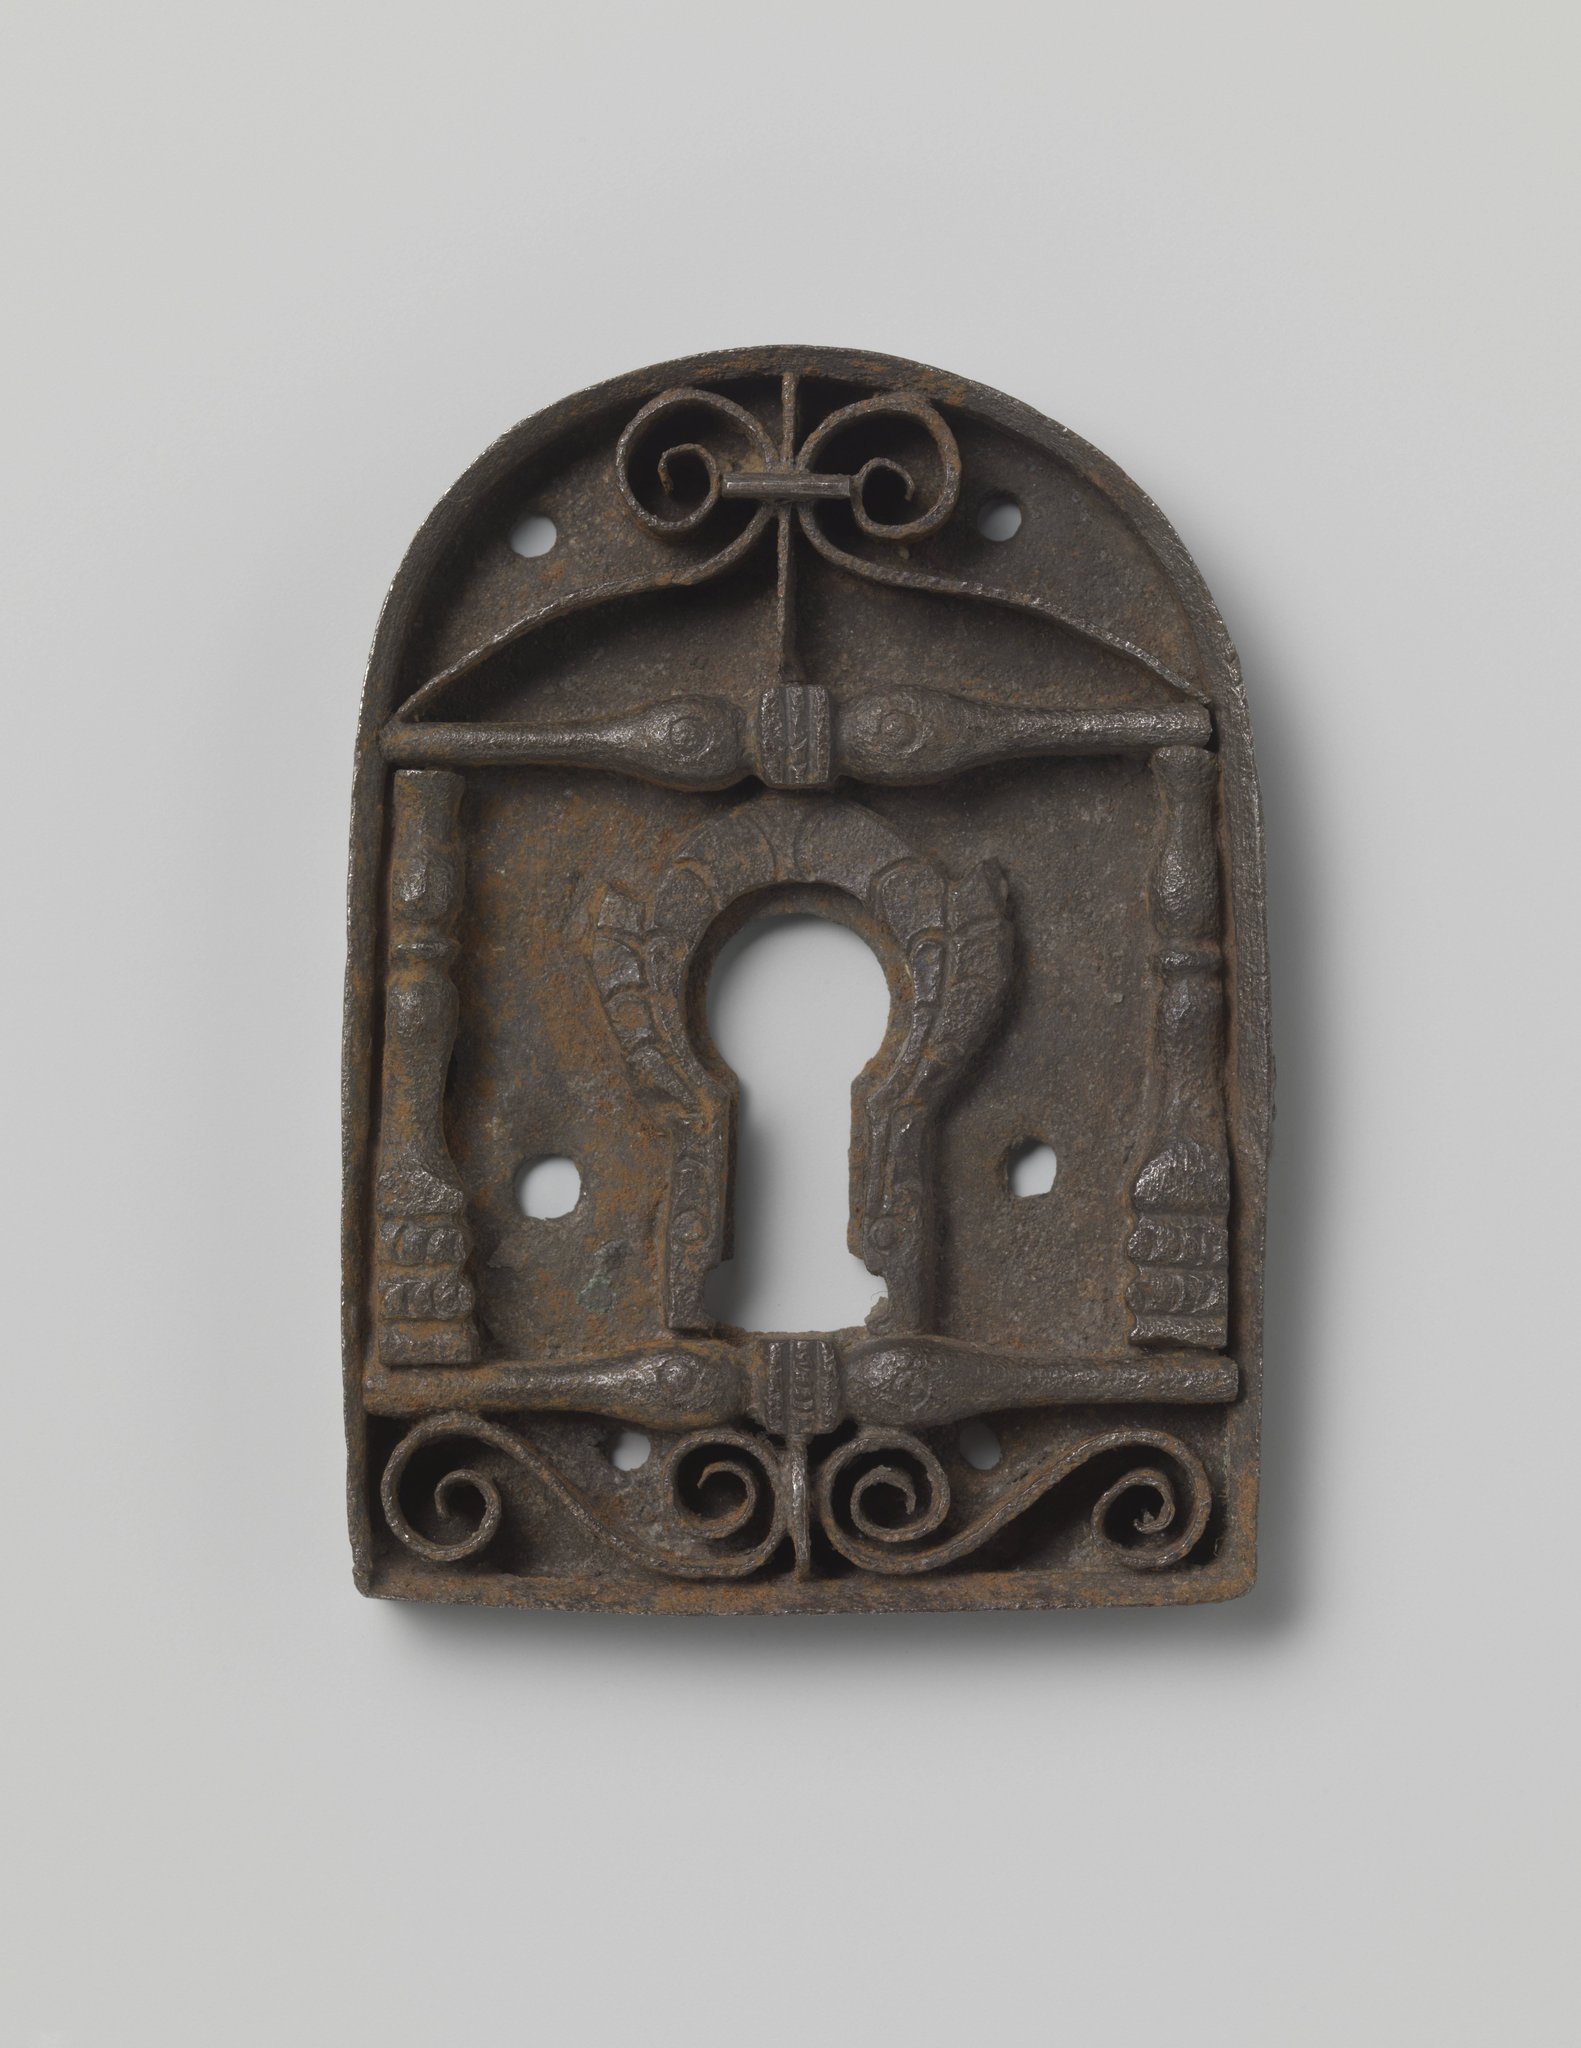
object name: key plate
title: Sleutelplaat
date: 1400-1950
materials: iron